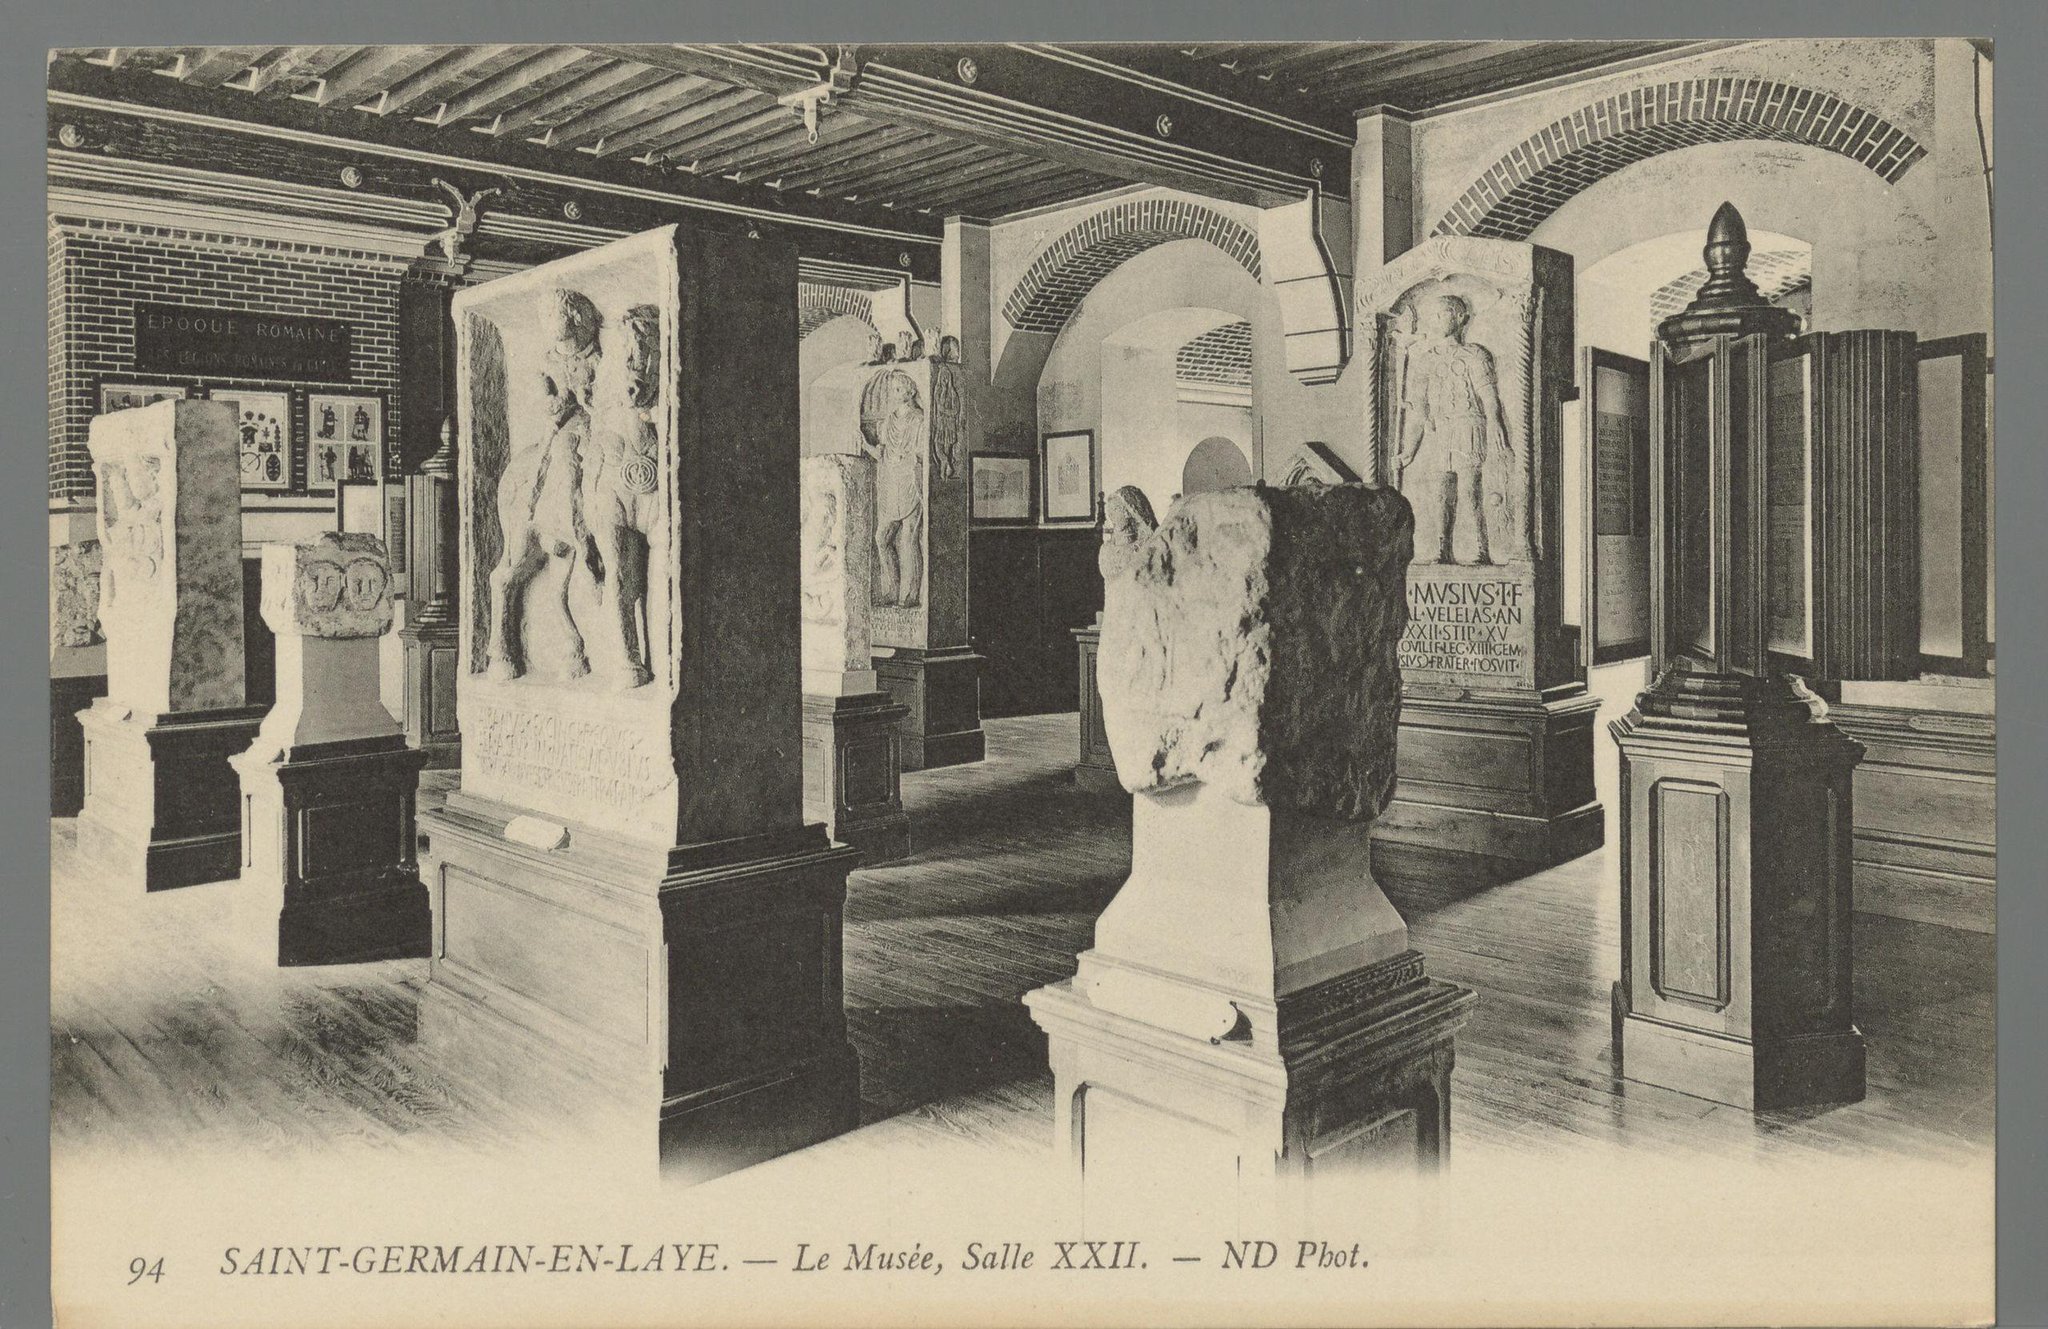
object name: ansichtkaart, prentbriefkaart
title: Saint-Germain-en-Laye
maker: Anonymous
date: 1903-1918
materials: cardboard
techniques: photograph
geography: paris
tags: permanent exhibition, museum, interior ~ representation of a building